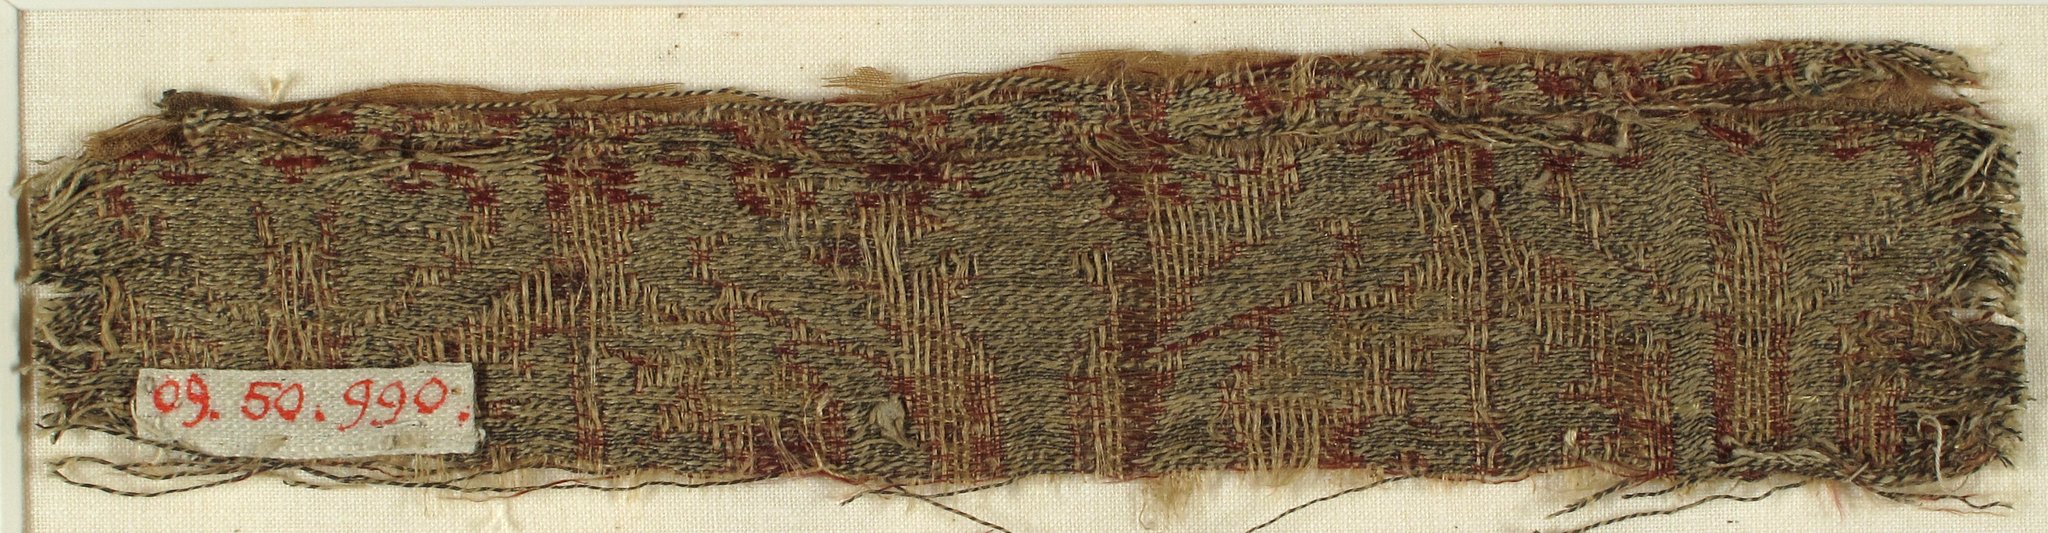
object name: textile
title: Textile with Confronted Parrots and Conventional Foliage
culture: german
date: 1101-1300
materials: linen, silk